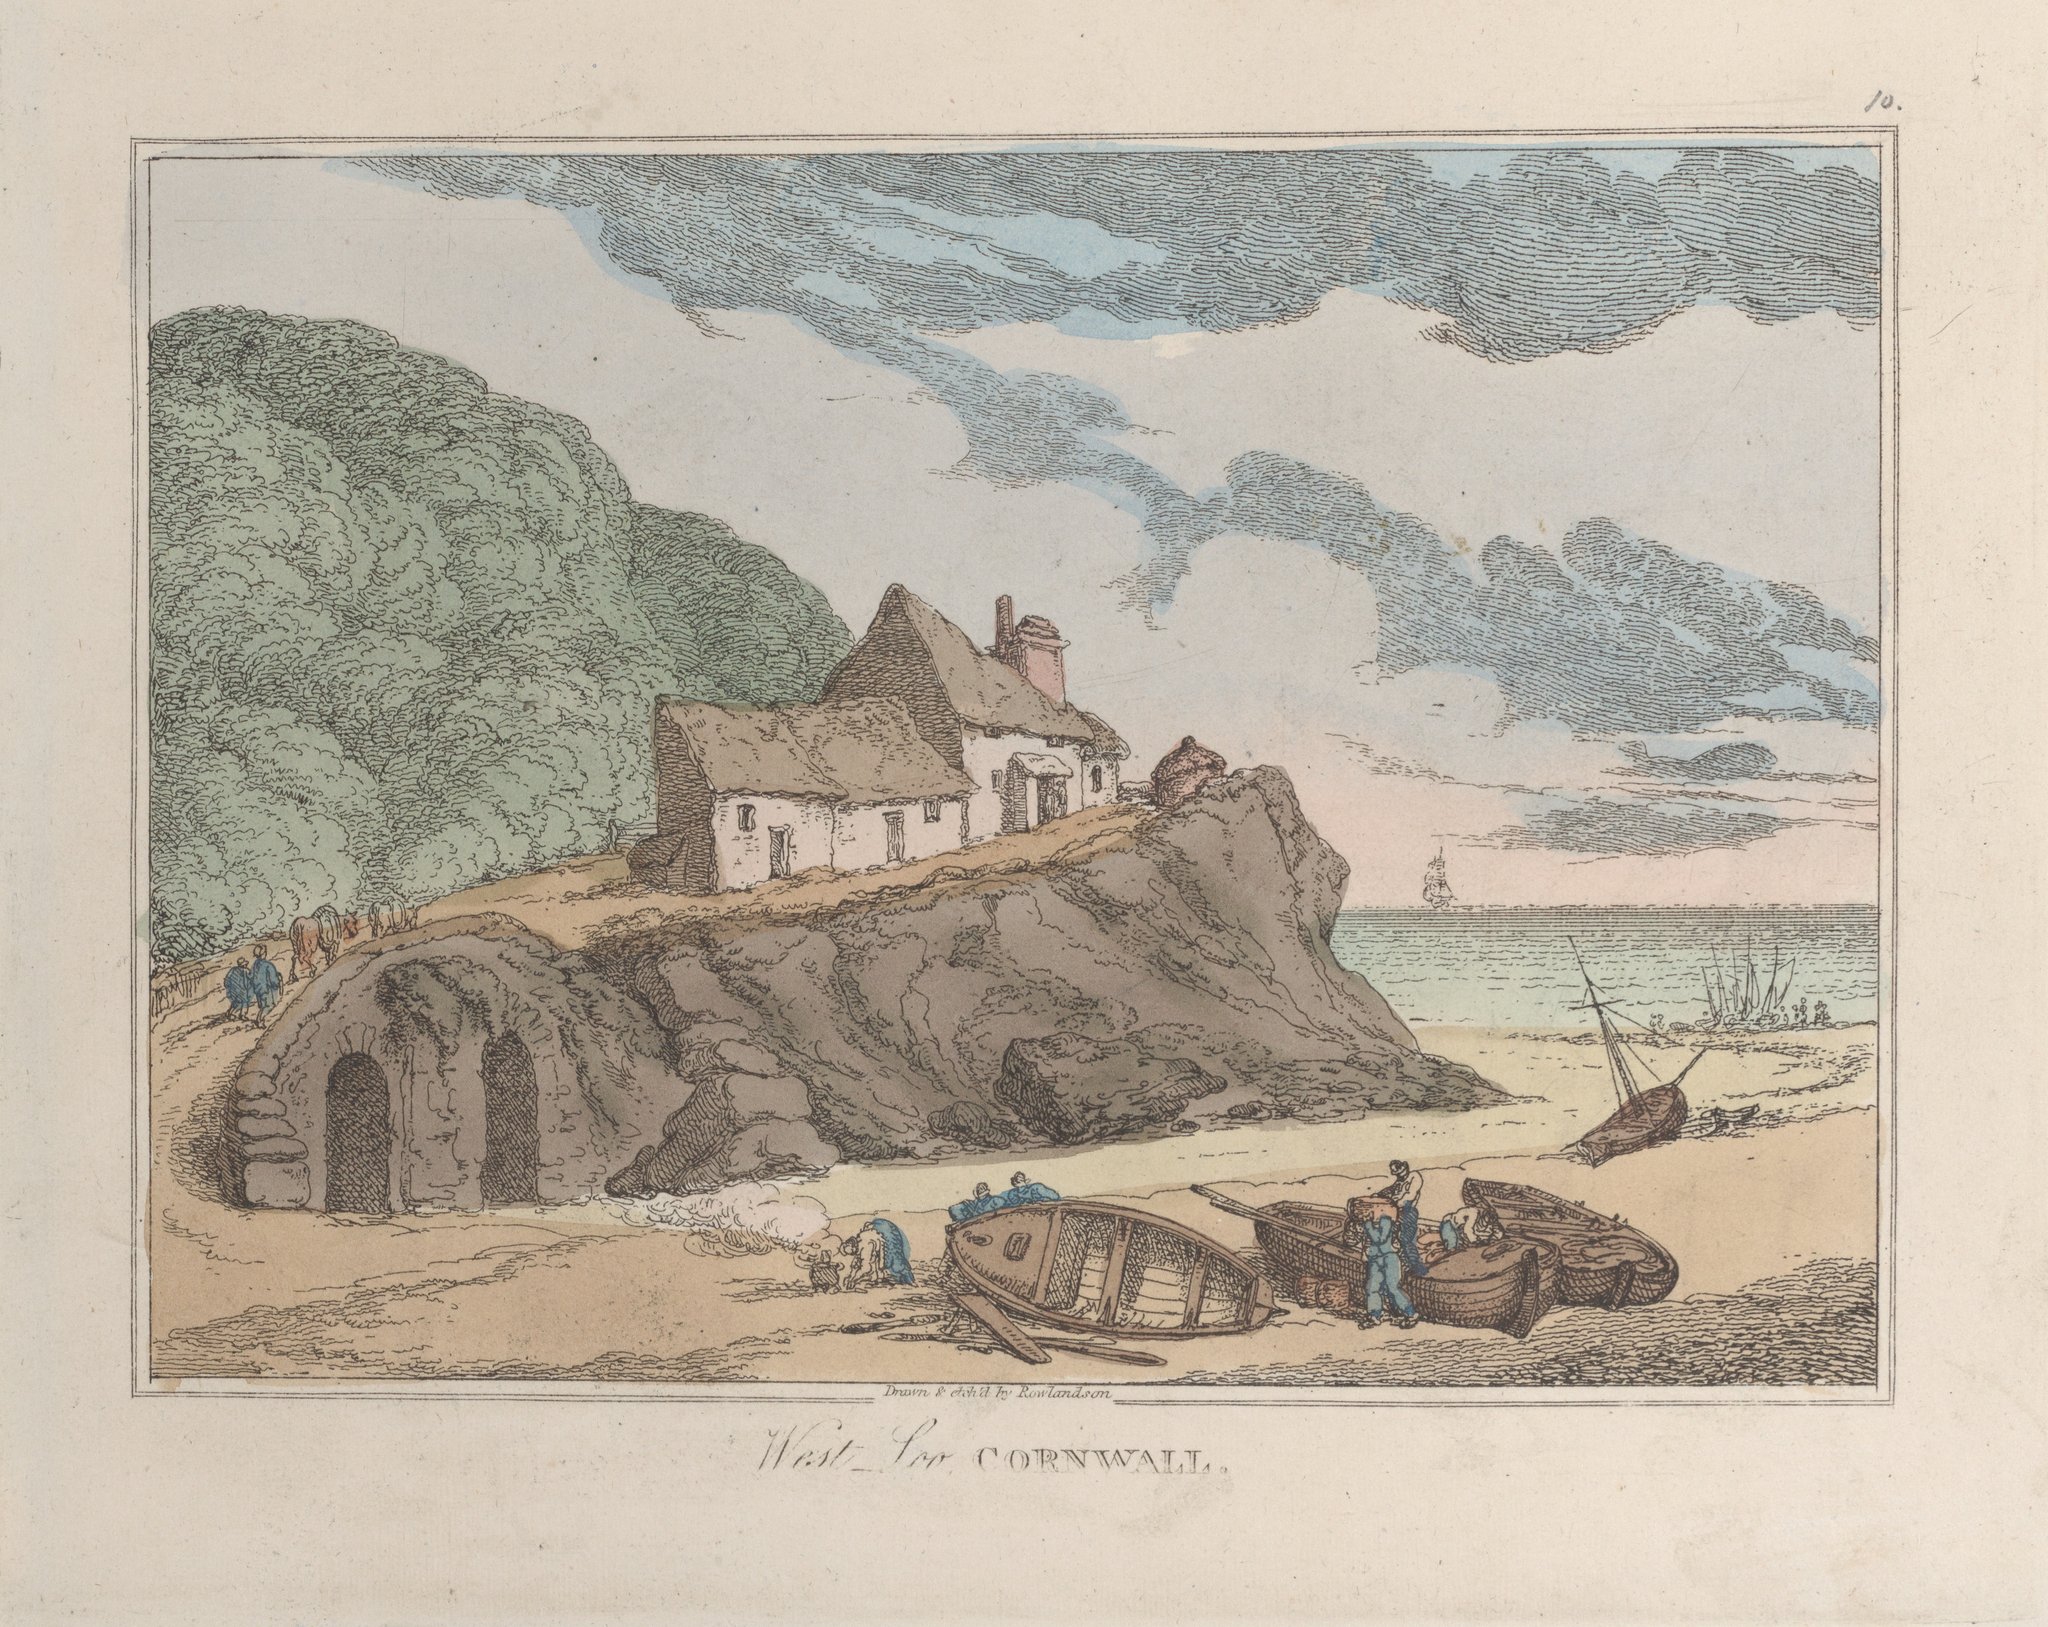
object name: print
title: West Loo, Cornwall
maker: thomas rowlandson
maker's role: artist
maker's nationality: british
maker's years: 1757-1827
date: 1822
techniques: etching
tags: landscapes,boats